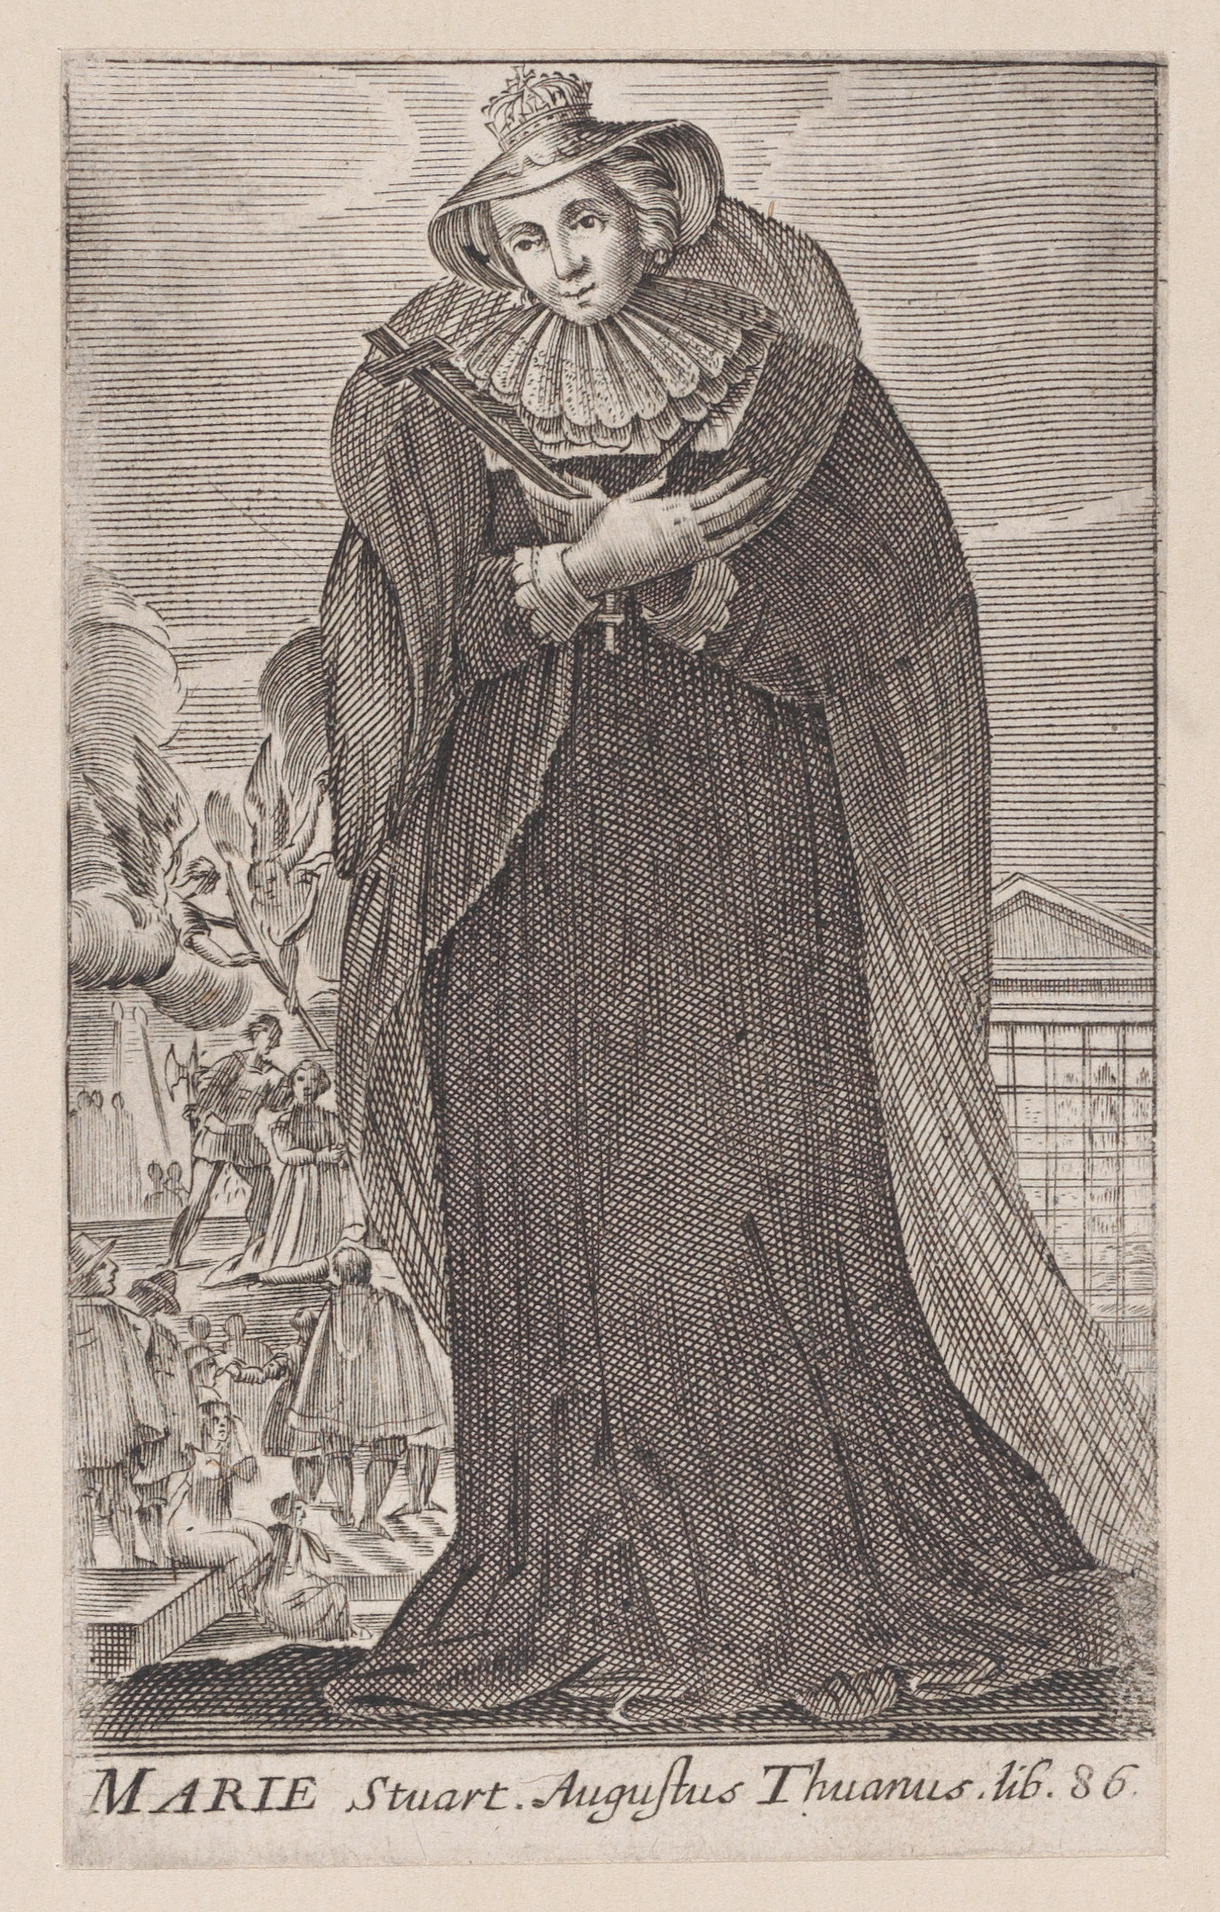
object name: print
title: Mary, Queen of Scots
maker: claude vignon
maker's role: artist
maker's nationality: french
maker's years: 1593-1670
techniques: engraving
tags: queens,portraits,women,cross,mary queen of scots